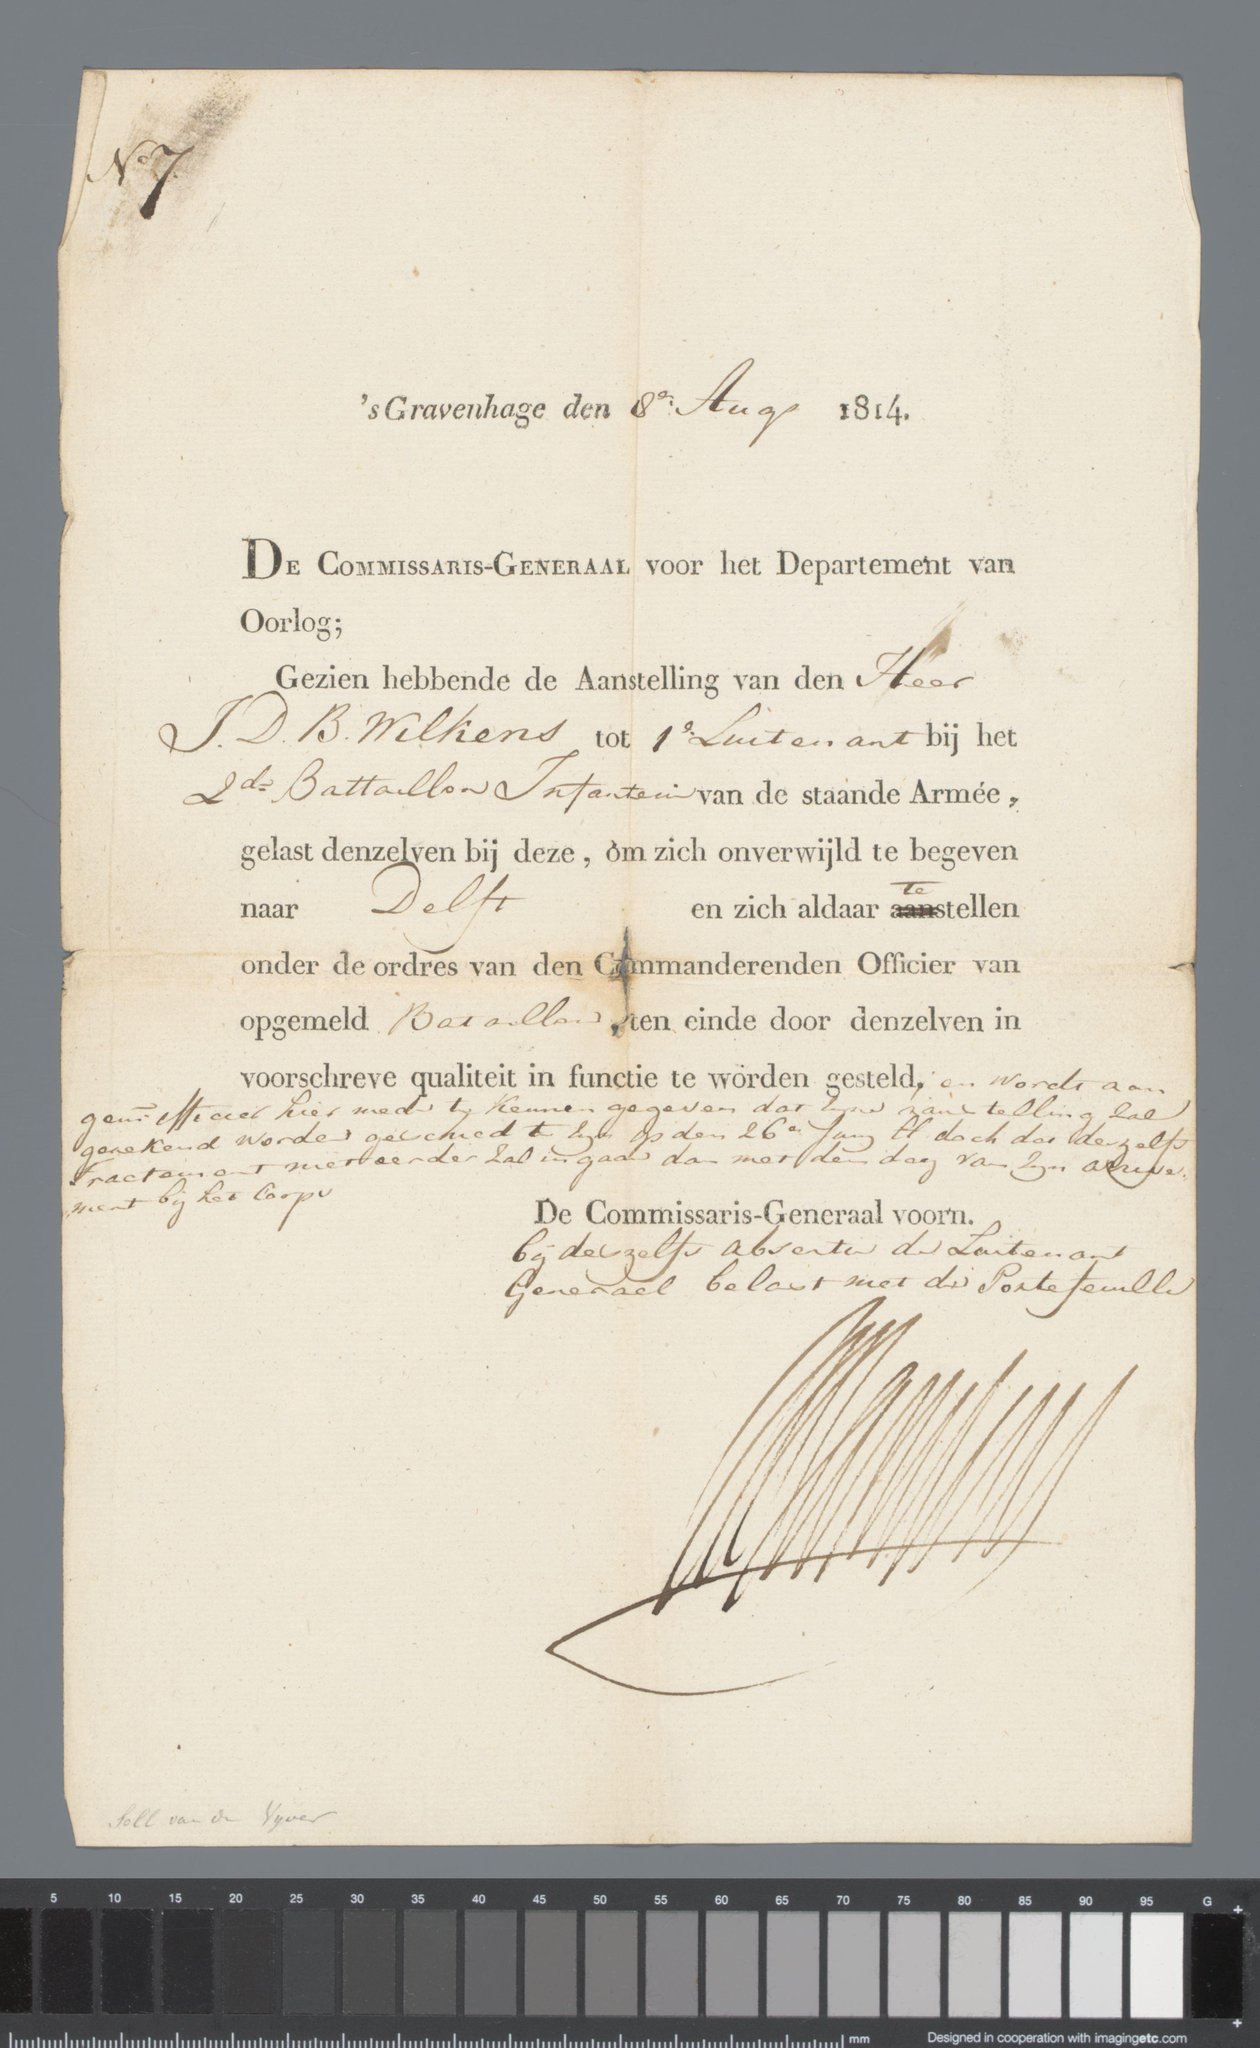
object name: letter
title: Benoeming van J.D.B. Wilkens tot Ridder der Orde van de Eikenkroon, 9 december 1843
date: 1843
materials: ink, paper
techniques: handwriting, pen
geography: the hague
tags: amsterdam, military service, netherlands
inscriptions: number: ‘11198’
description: Onderdeel van een groep van documenten betreffende de staat van dienst, benoemingen, enz. van Luitenant Kolonel van de Infanterie J.D.B. Wilkens. Behorende bij de schenking van het geschilderde portret.